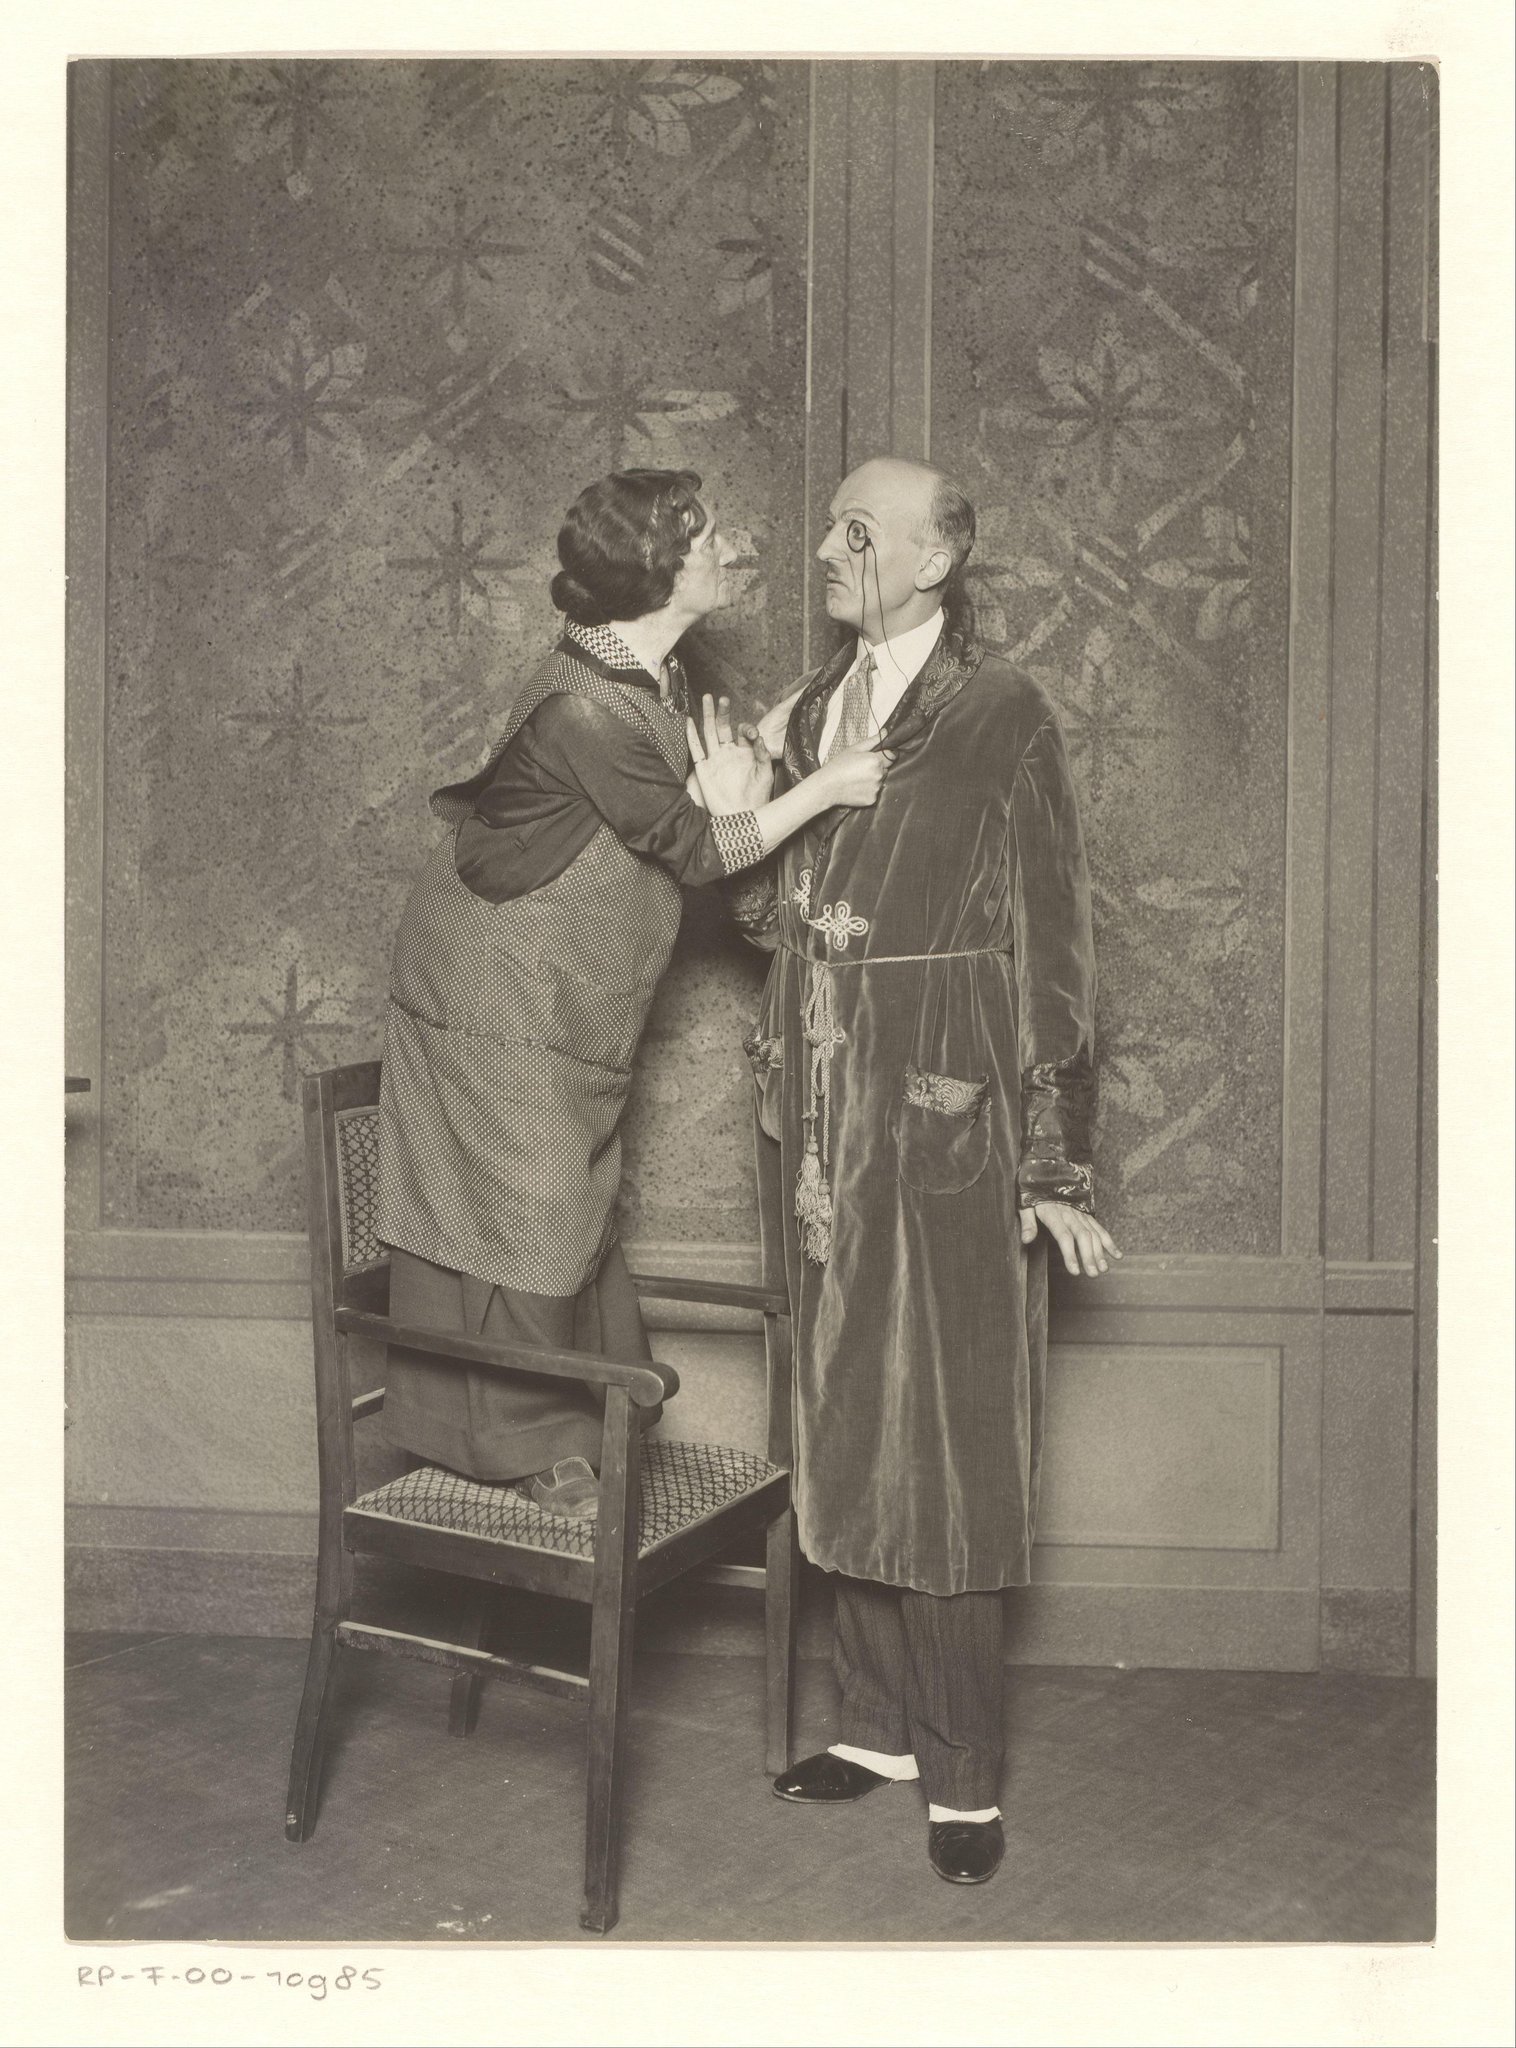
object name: photograph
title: Opvoering van het toneelstuk 'De tante uit Indië' van Henri van Wermeskerken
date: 1928-1970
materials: photographic support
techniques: gelatin silver print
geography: amsterdam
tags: theatre, theatrical performance, monocle, single lorgnette, chair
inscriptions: annotation: ‘Toneelstuk/ De Tante uit Indië’, collector's mark: Lugt 2228a, :, copyright notice: ‘COPYRIGHT/ N.V. VEREENIGDE FOTOBUREAUX/ NIEUWE HEERENGRACHT 105/ AMSTERDAM’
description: Een lange man gekleed in een pak met kamerjas en met een monocle staat tegenover een vrouw in een interieur. De vrouw staat op een stoel om op gelijke hoogte te zijn met de man en pakt de revers van zijn kamerjas vast.